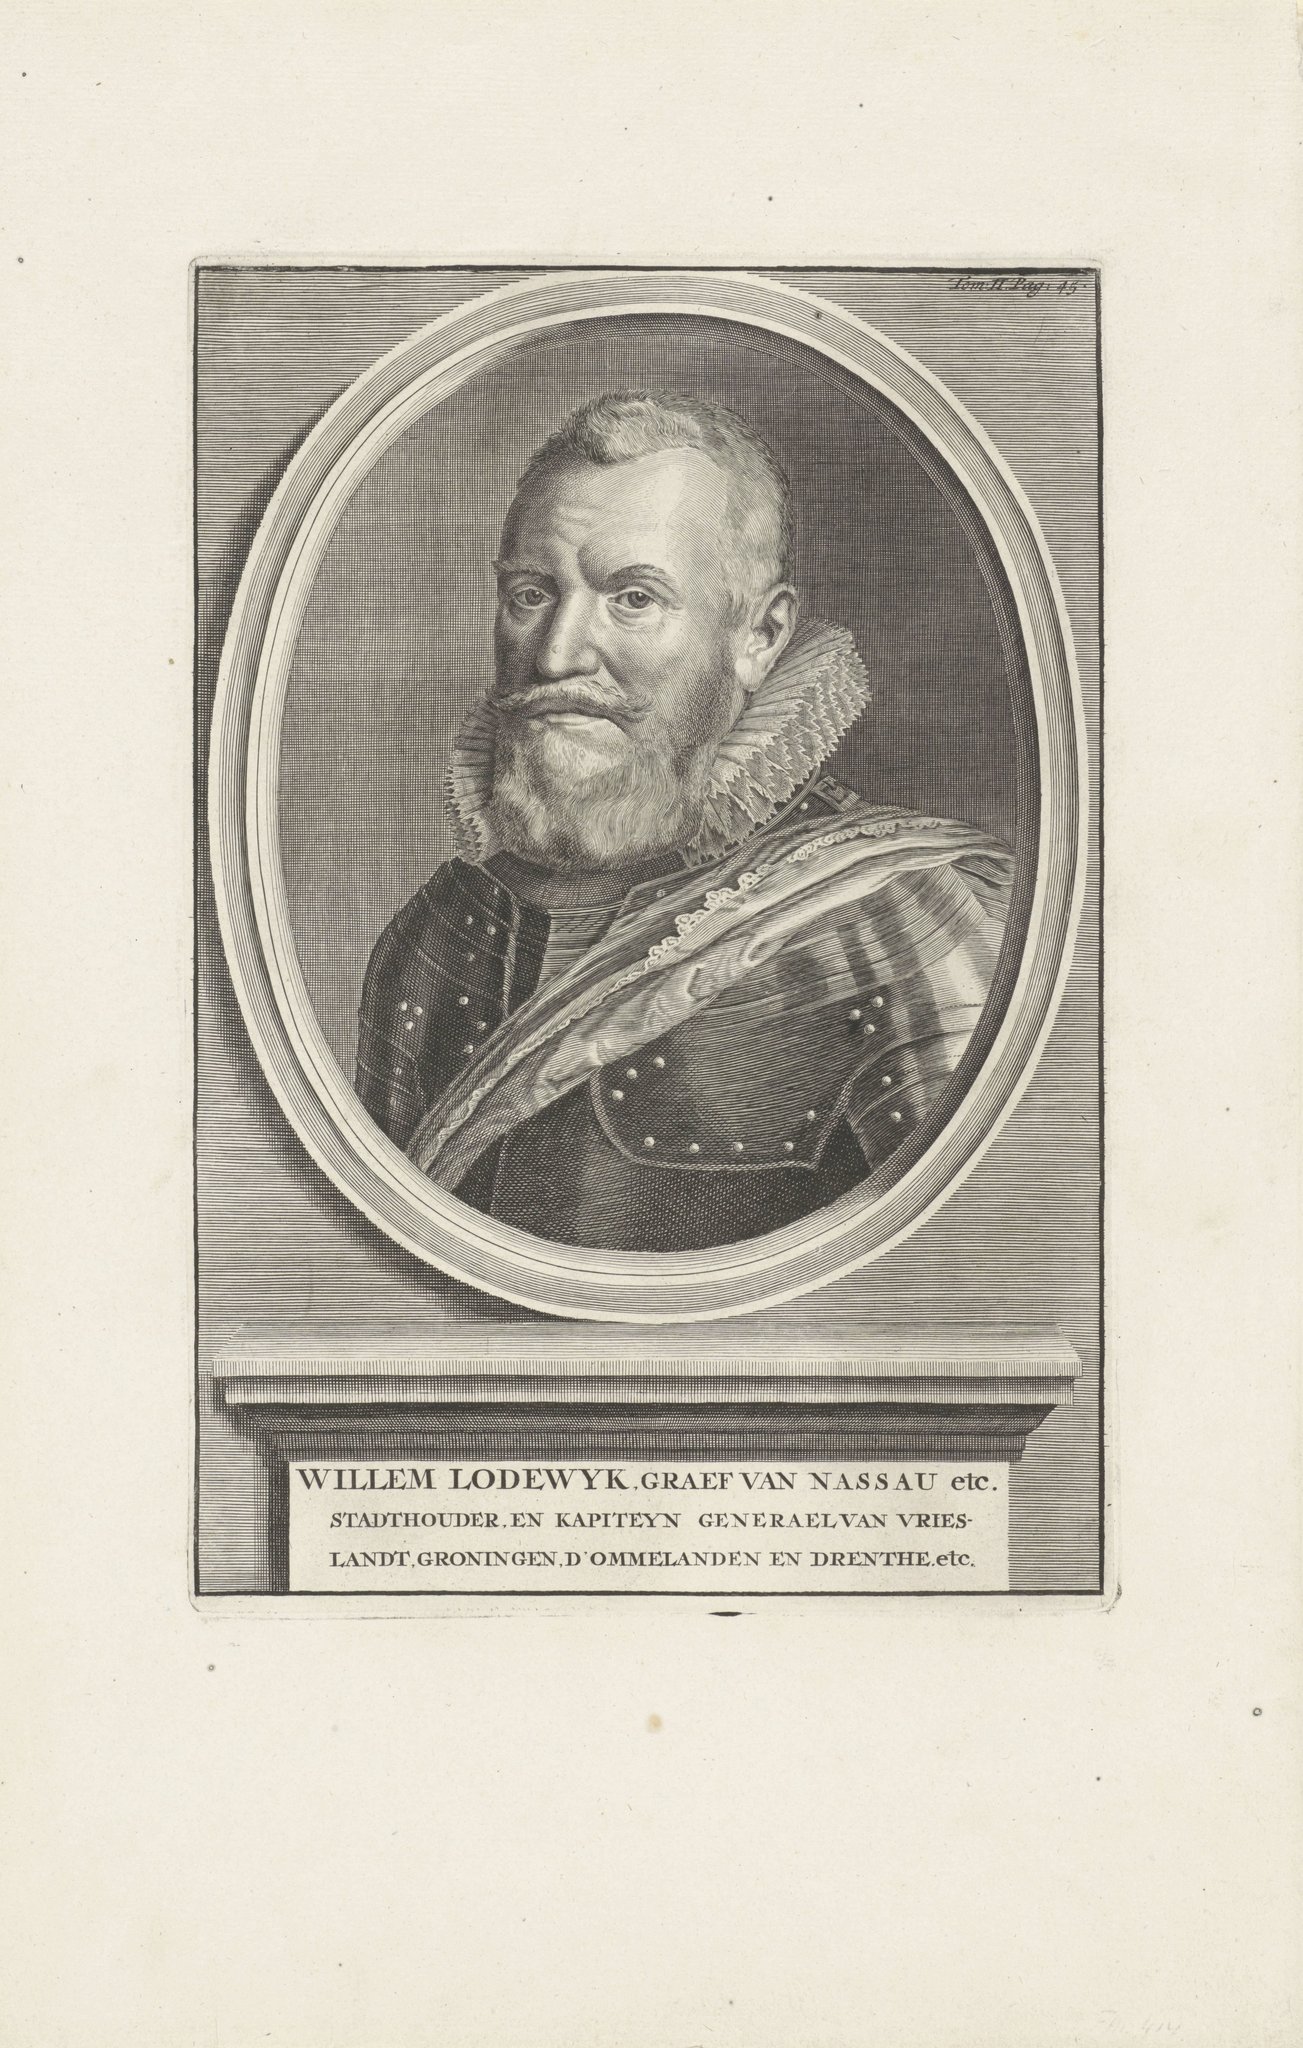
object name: book illustration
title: Portret van Willem Lodewijk, graaf van Nassau-Dillenburg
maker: bernard picart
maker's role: draughtsman, print maker, publisher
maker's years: 1673-1733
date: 1693-1733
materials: paper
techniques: engraving, etching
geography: low countries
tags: willem lodewijk graaf van nassau-dillenburg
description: De hier vermelde titel verwijst naar de hoogst verkregen titel van de geportretteerde, niet per se naar de titel die de geportretteerde op deze voorstelling draagt.